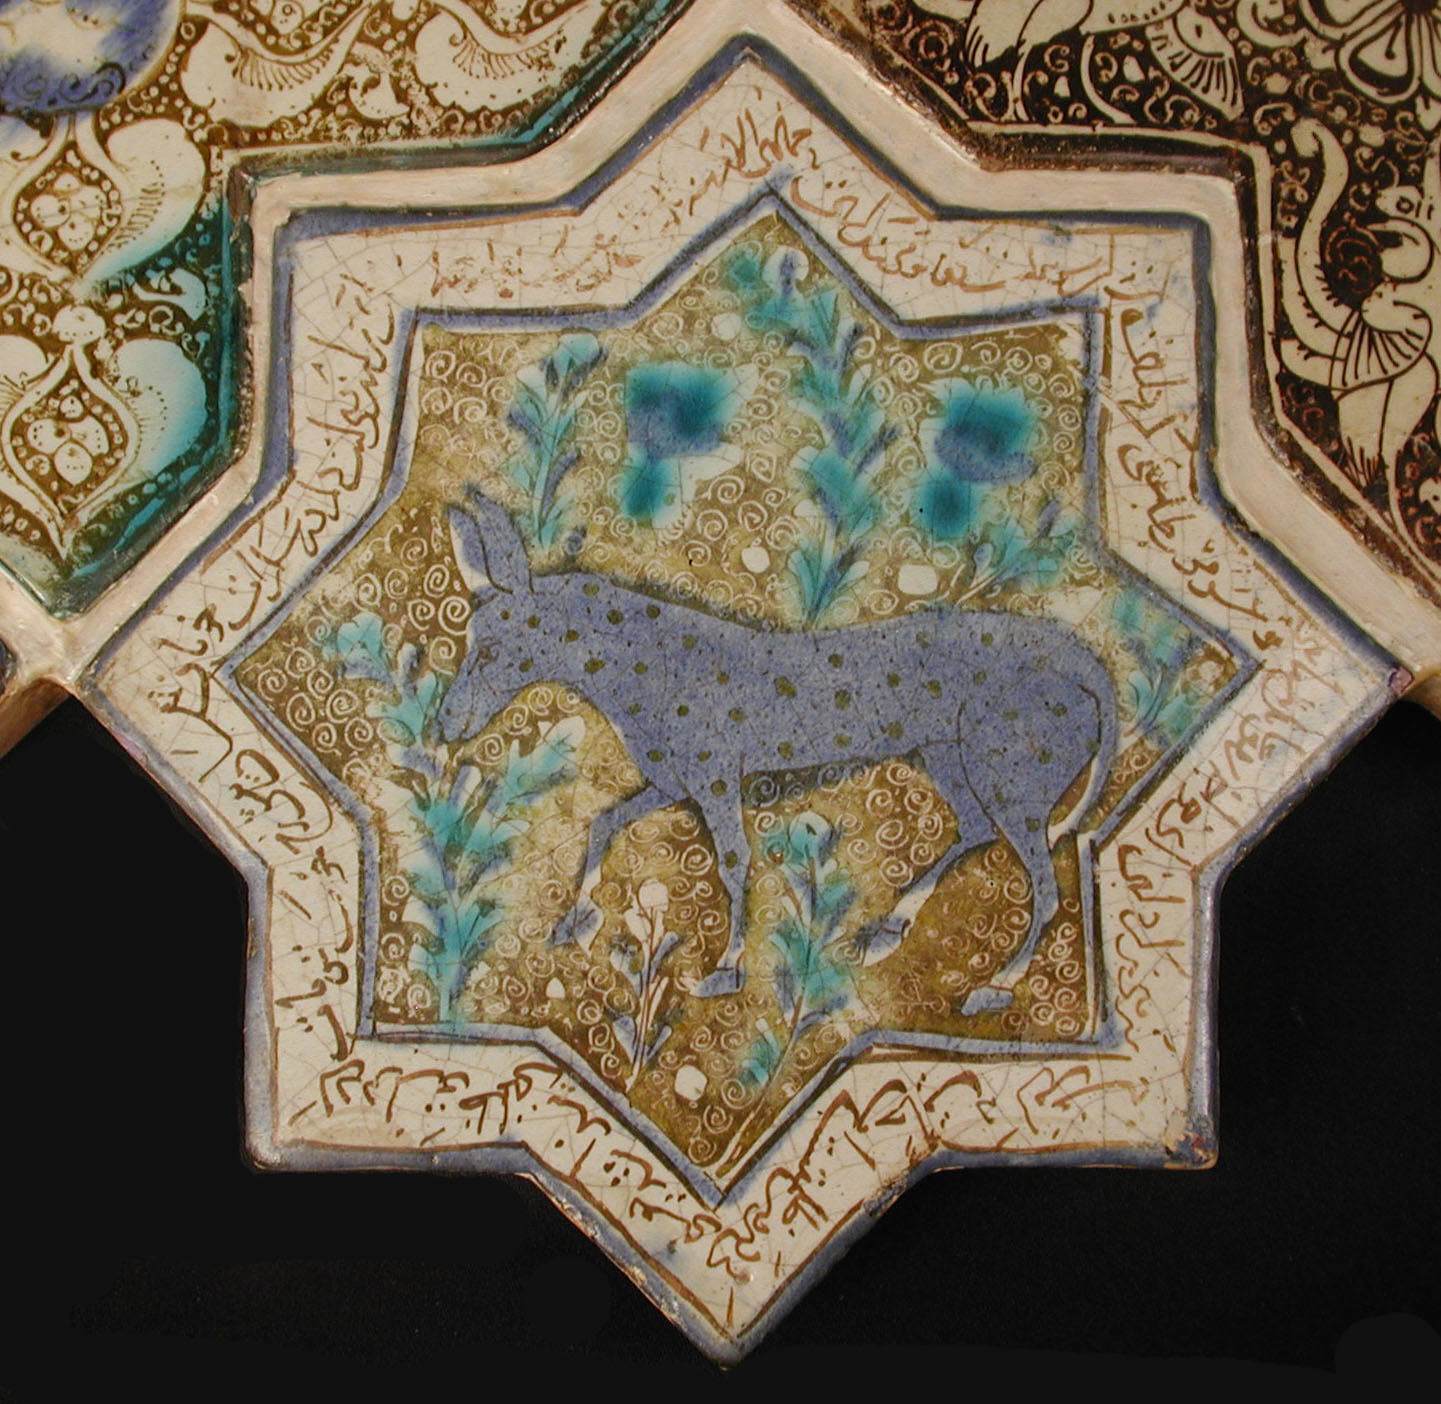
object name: tile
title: Star-Shaped Tile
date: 1201-1400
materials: glaze, stonepaste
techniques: luster painting, painting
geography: iran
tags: donkeys